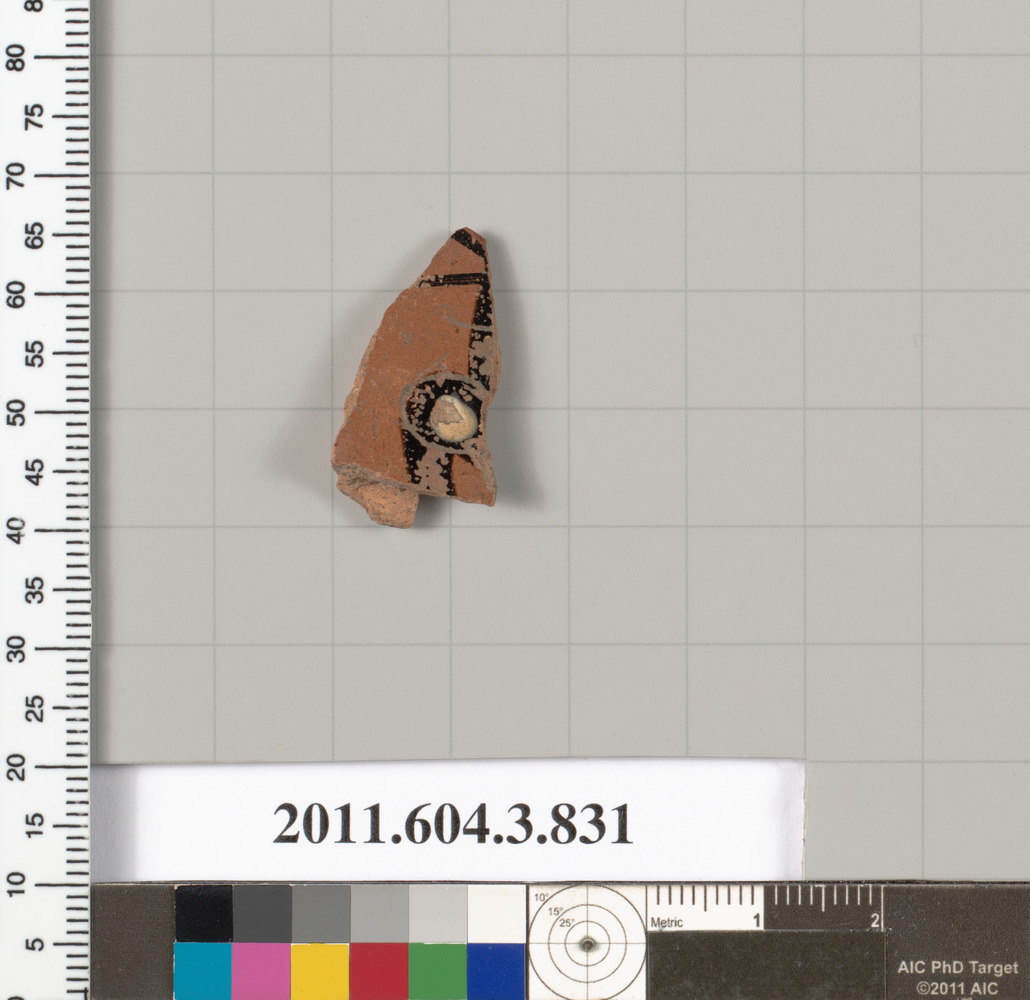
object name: lekythos fragment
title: Terracotta fragment of a lekythos (oil flask)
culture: greek, attic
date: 534-501 BCE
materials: terracotta